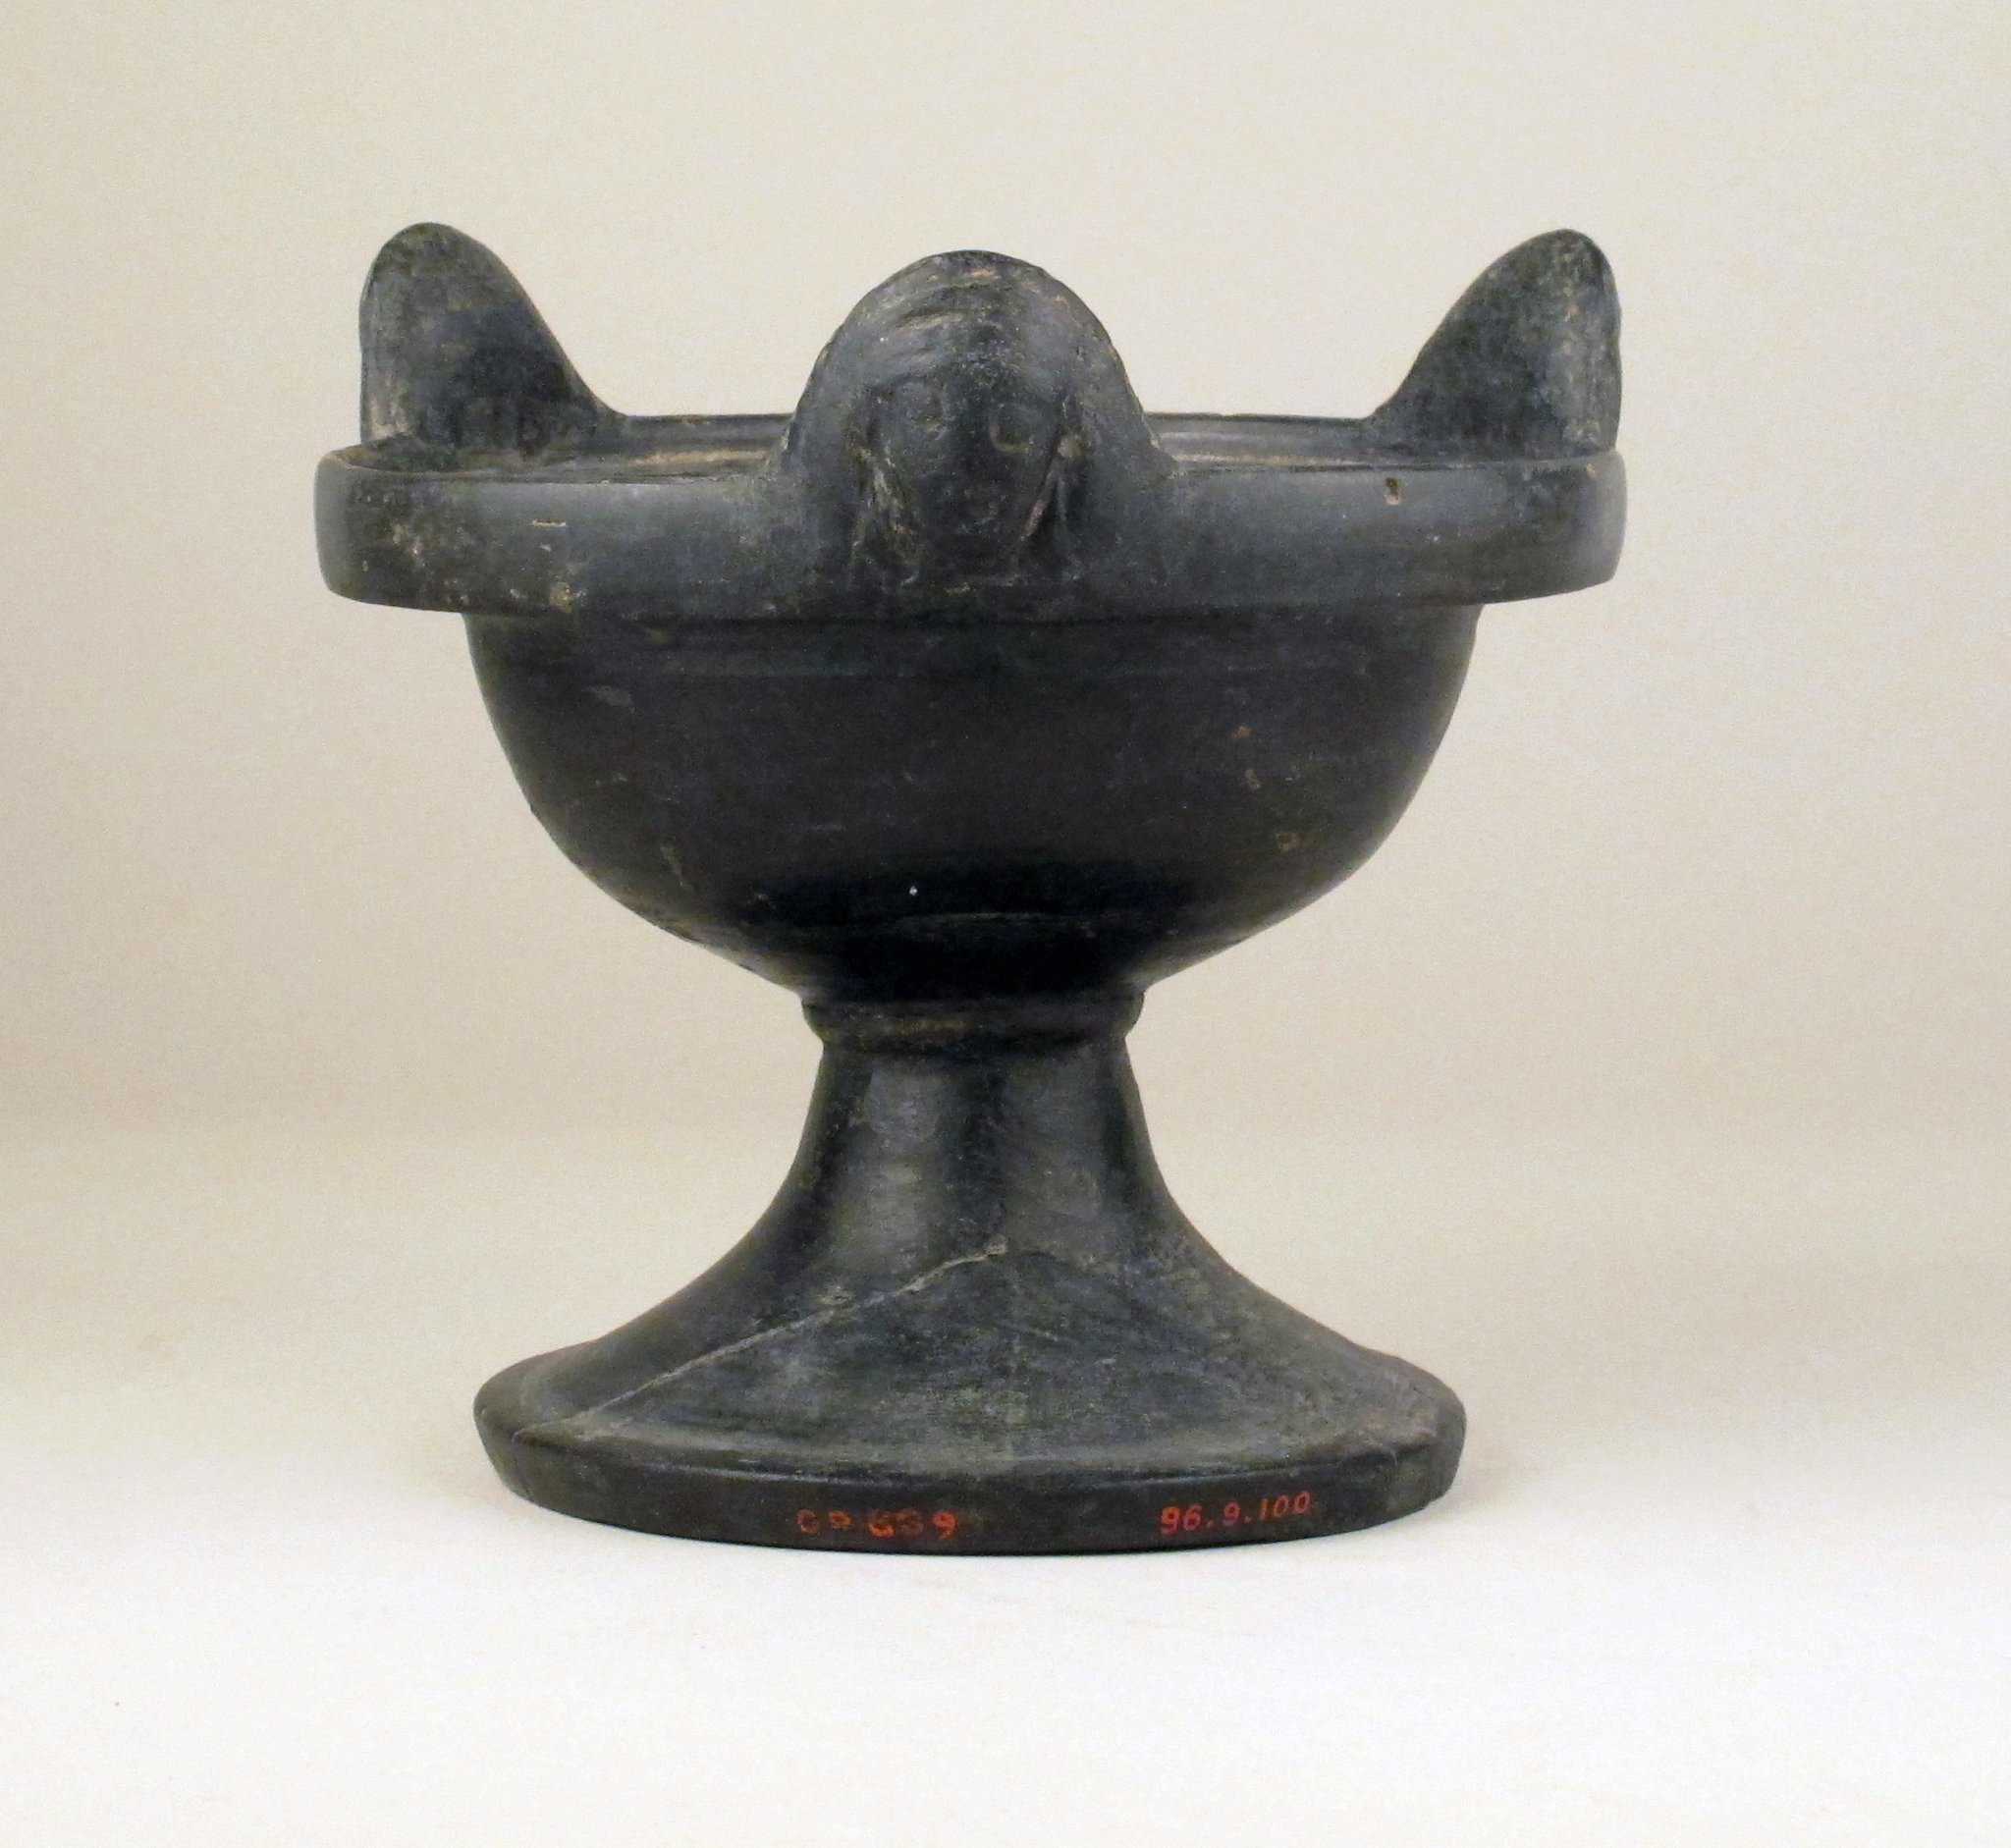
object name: cup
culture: etruscan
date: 550-500 BCE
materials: terracotta